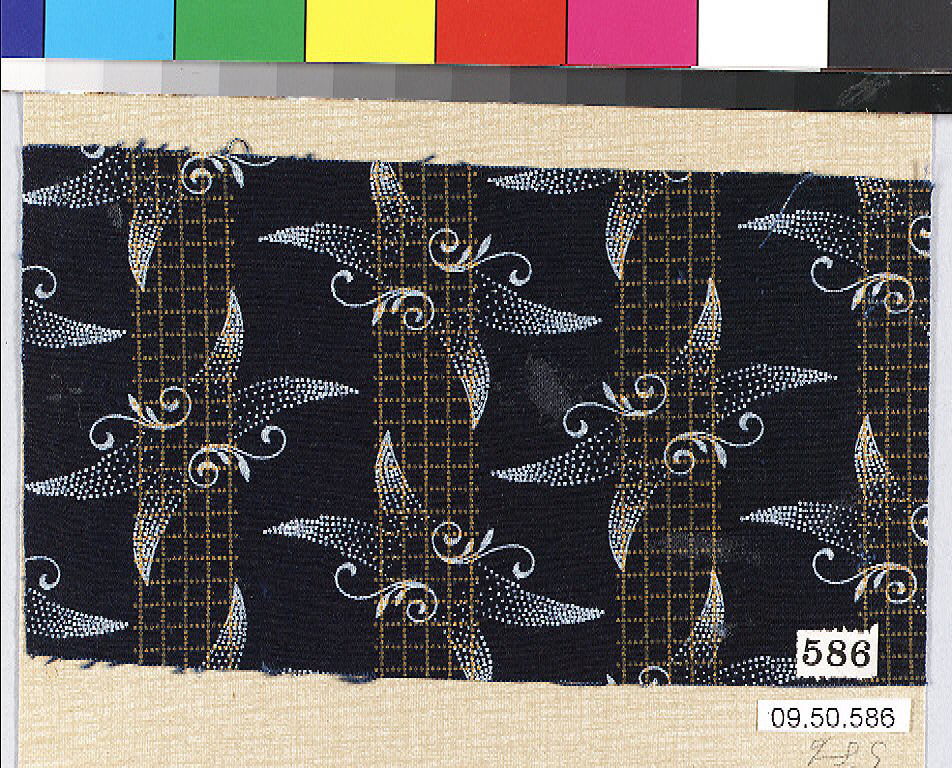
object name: piece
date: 1801-1900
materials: cotton